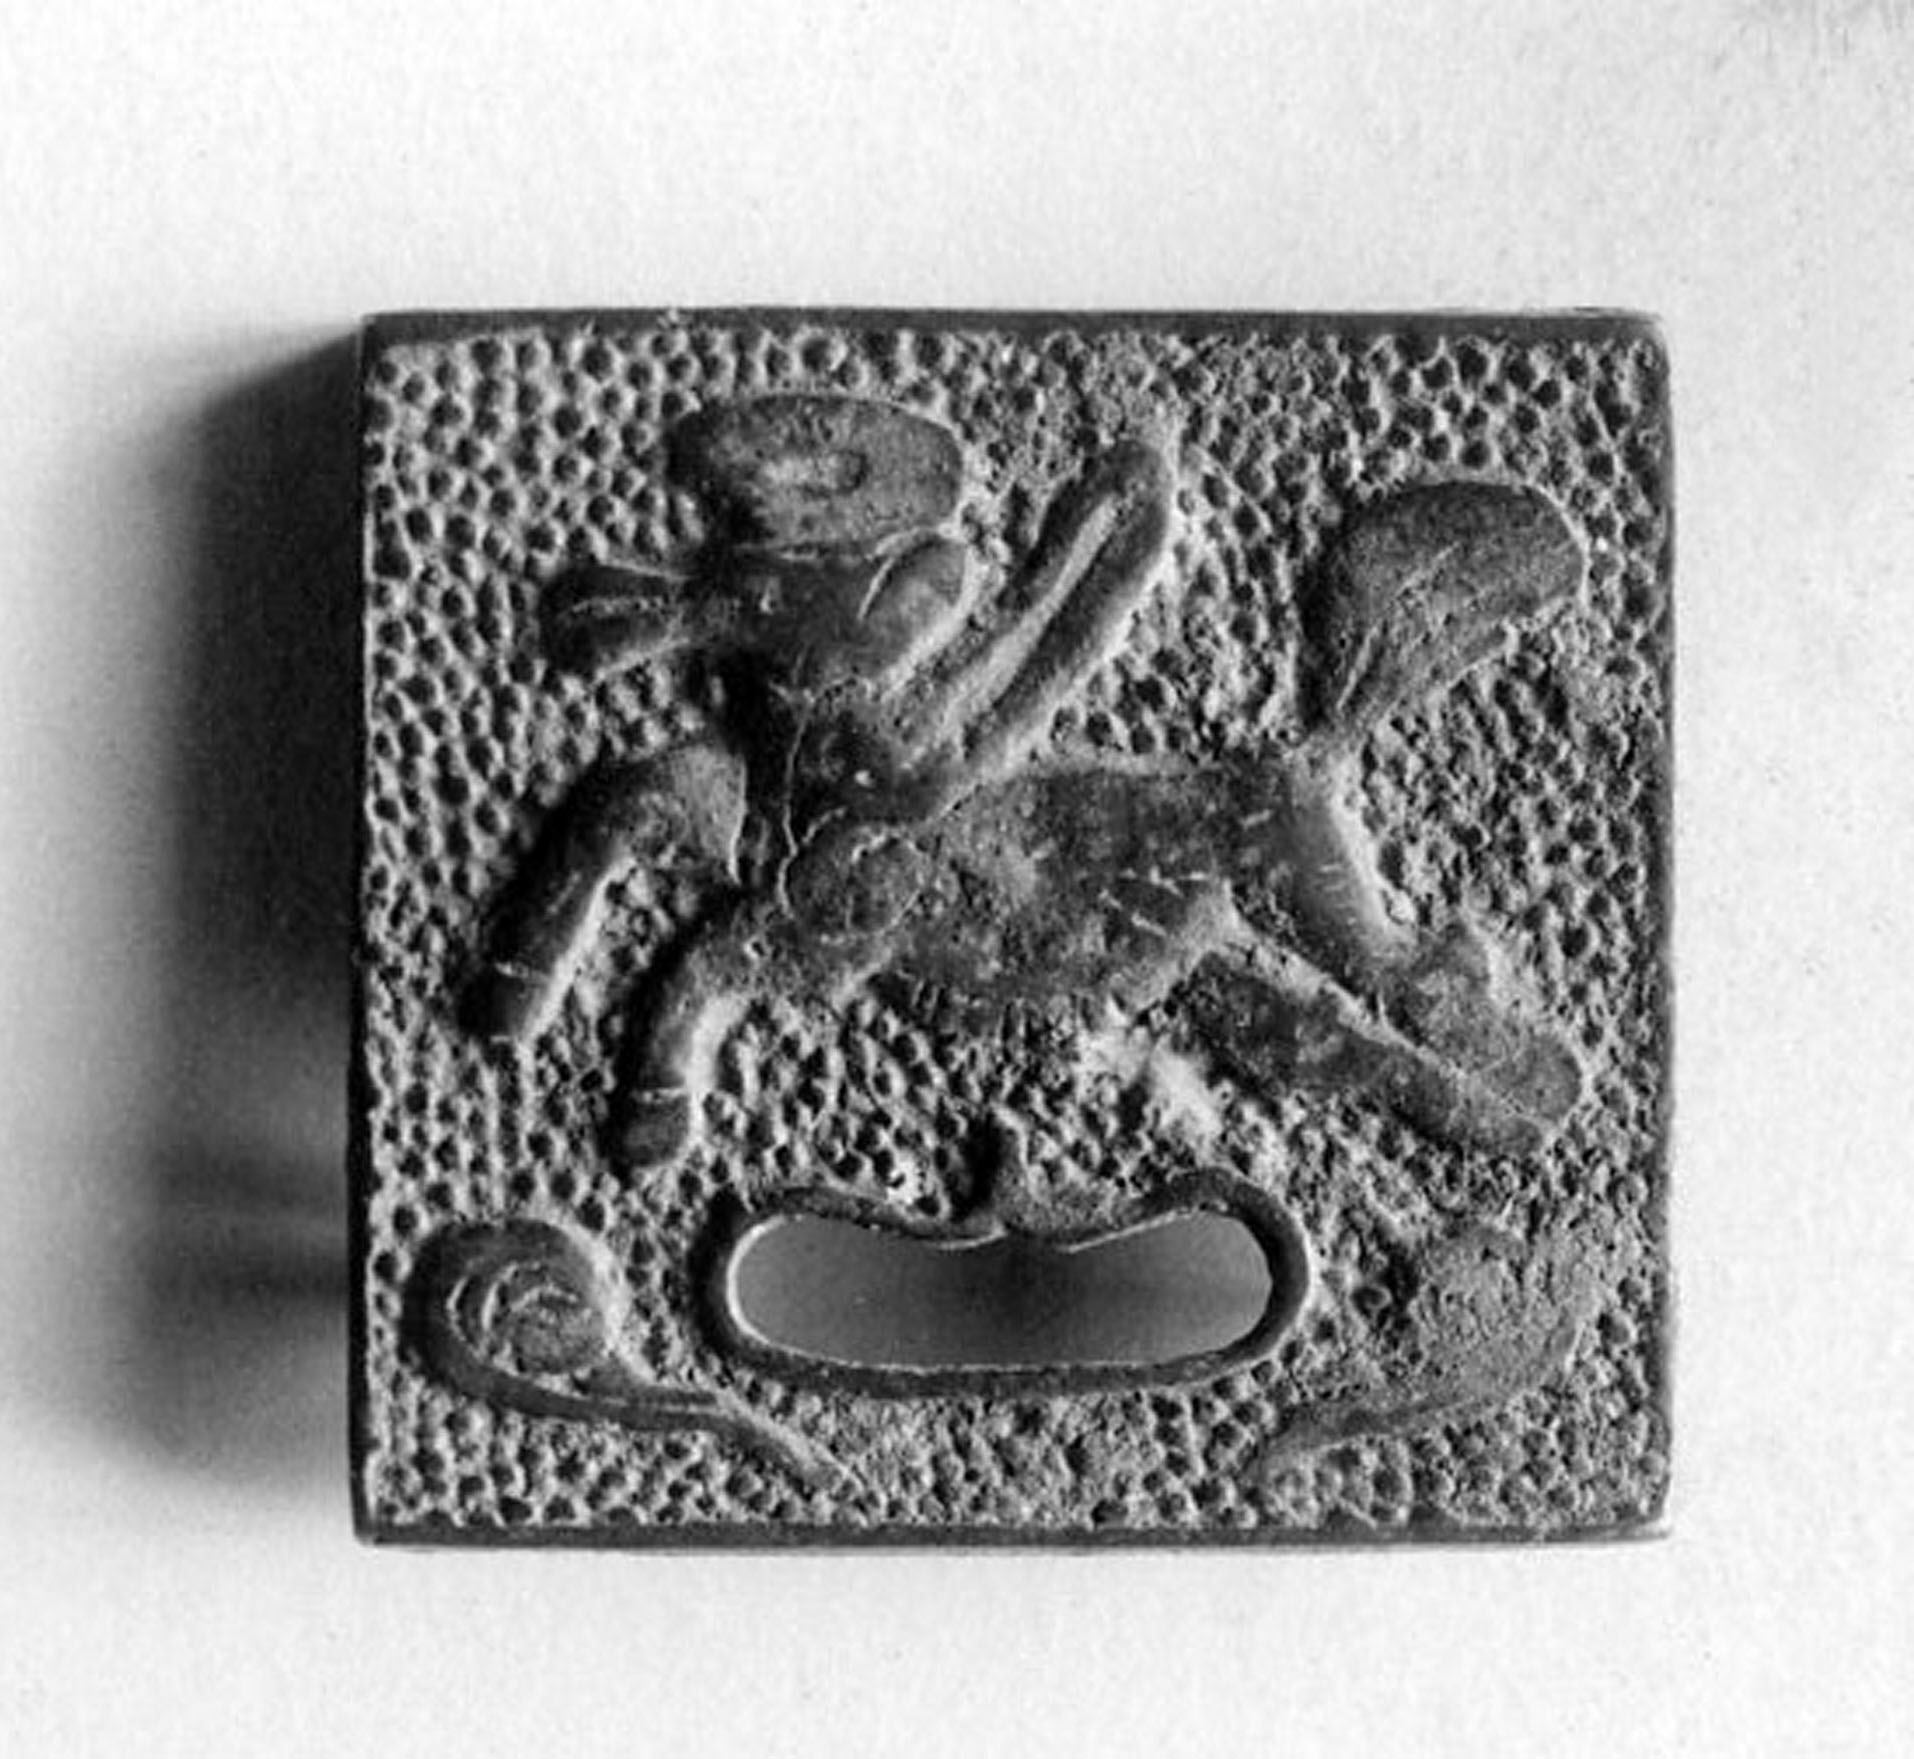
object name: belt plaque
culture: chinese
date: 201-600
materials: bronze